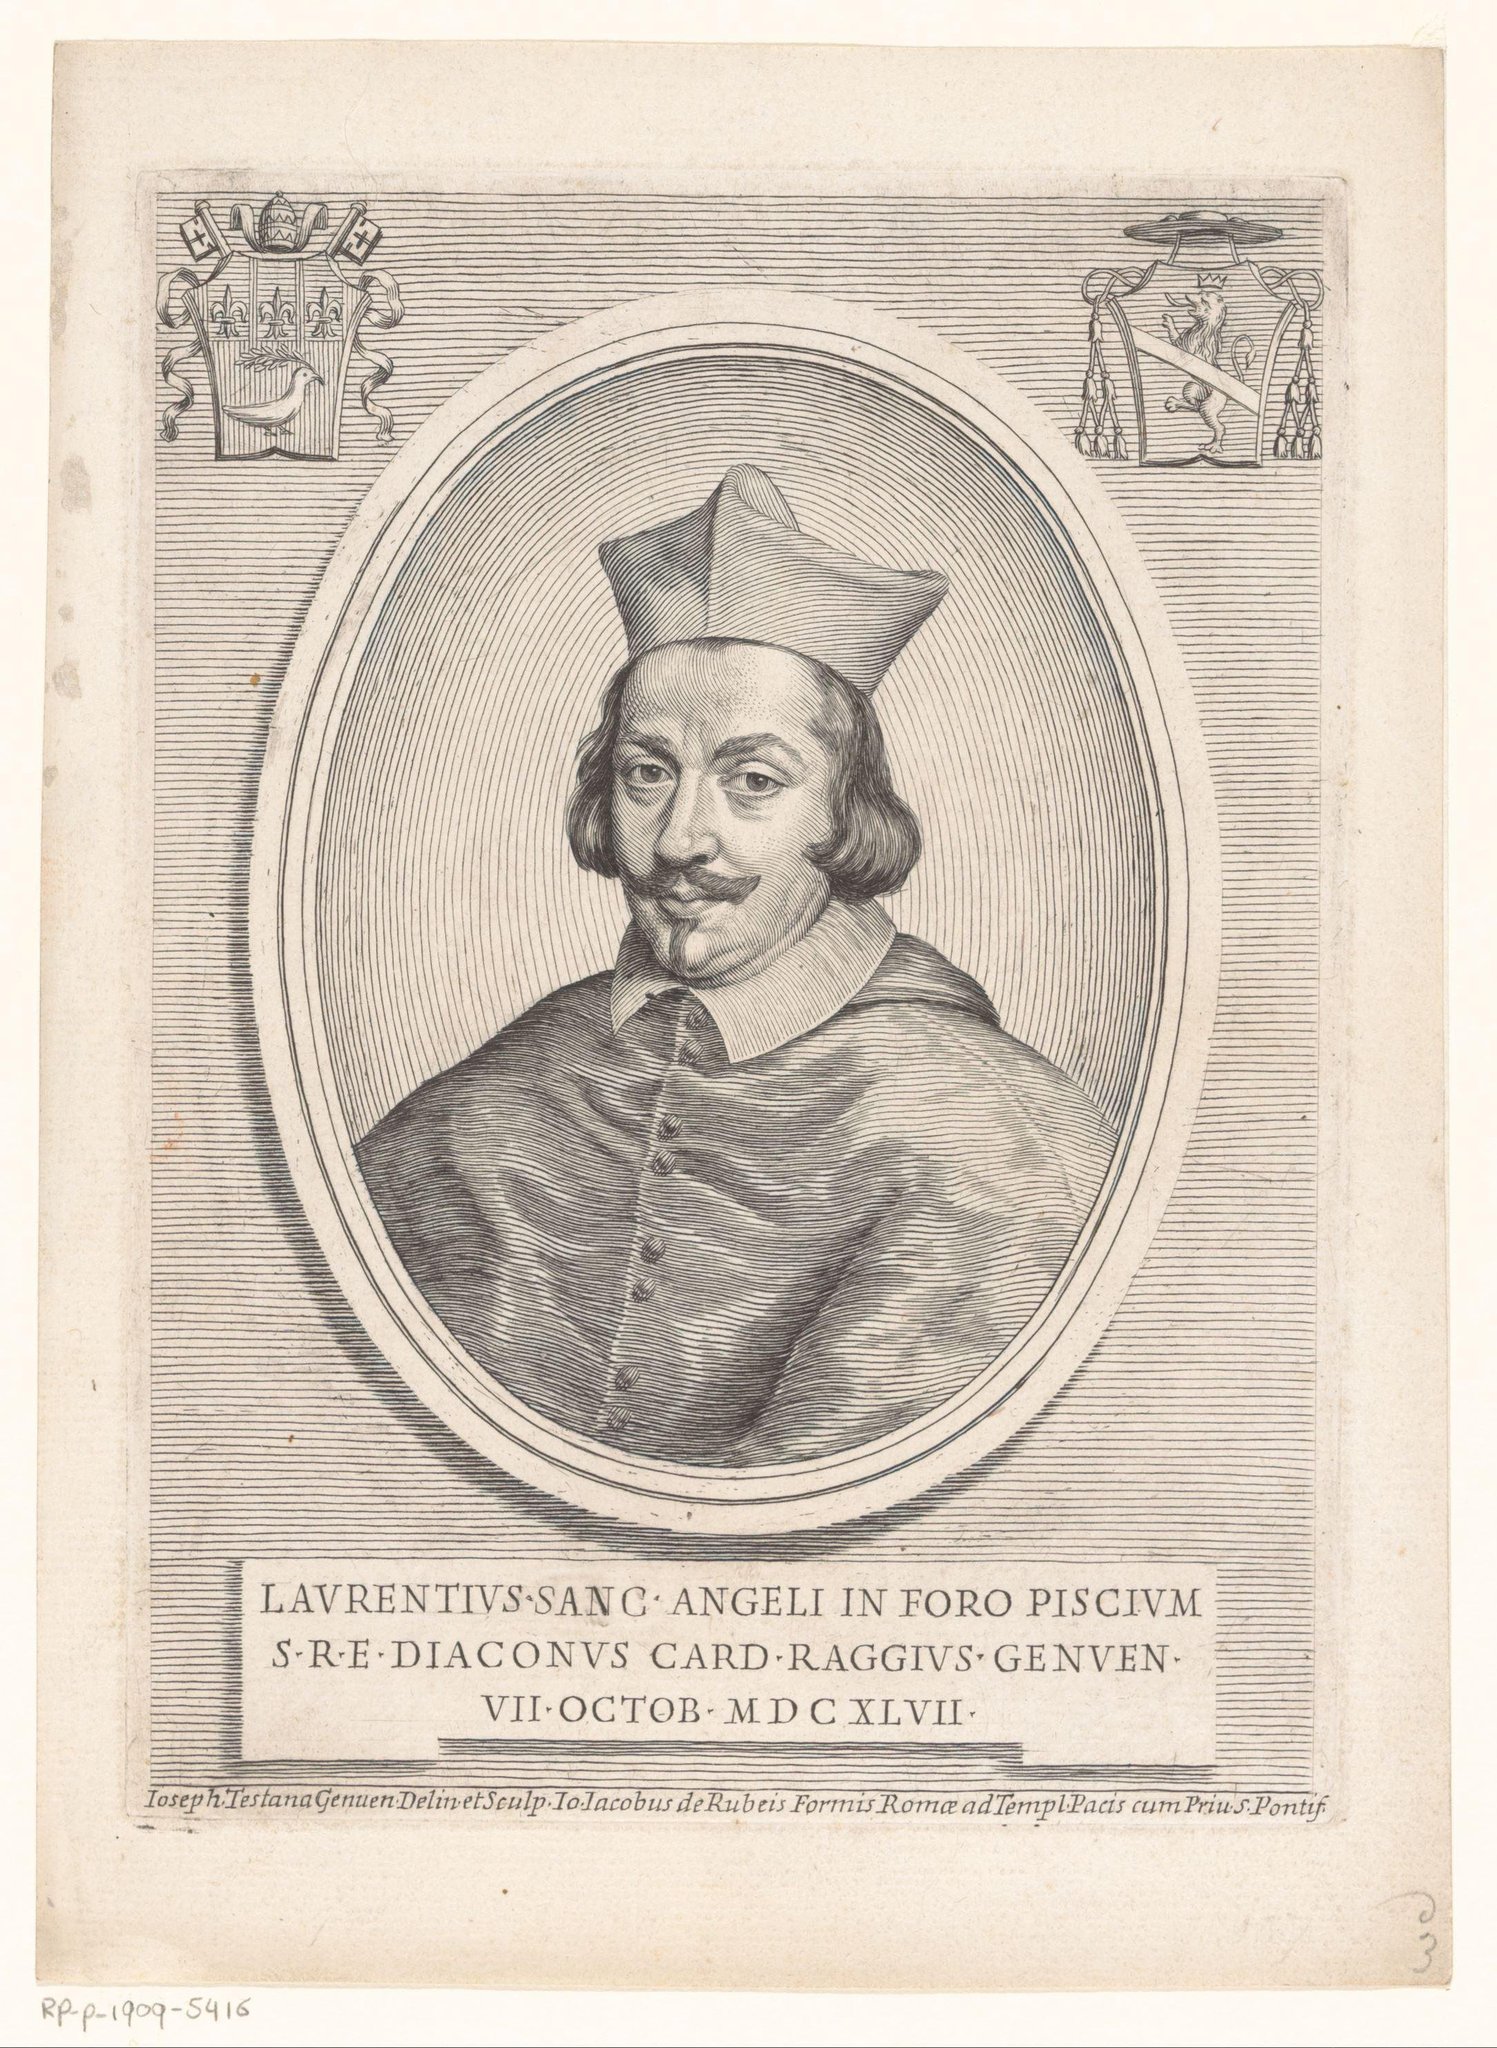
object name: print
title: Effigies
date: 1658-1679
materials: paper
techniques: engraving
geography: italy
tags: cardinal, historical persons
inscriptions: collector's mark: Lugt 2228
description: Prent uit een reeks van onbekende omvang met portretten van kardinalen. De prenten werden vanaf 1657 vervaardigd in opdracht van uitgever Giovanni Giacomo de’ Rossi, waarna de productie werd voortgezet onder leiding van zijn opvolgers Domenico de’ Rossi en Lorenzo Filippo de’ Rossi, en ten slotte onder leiding van de Calcographia R.C.A.